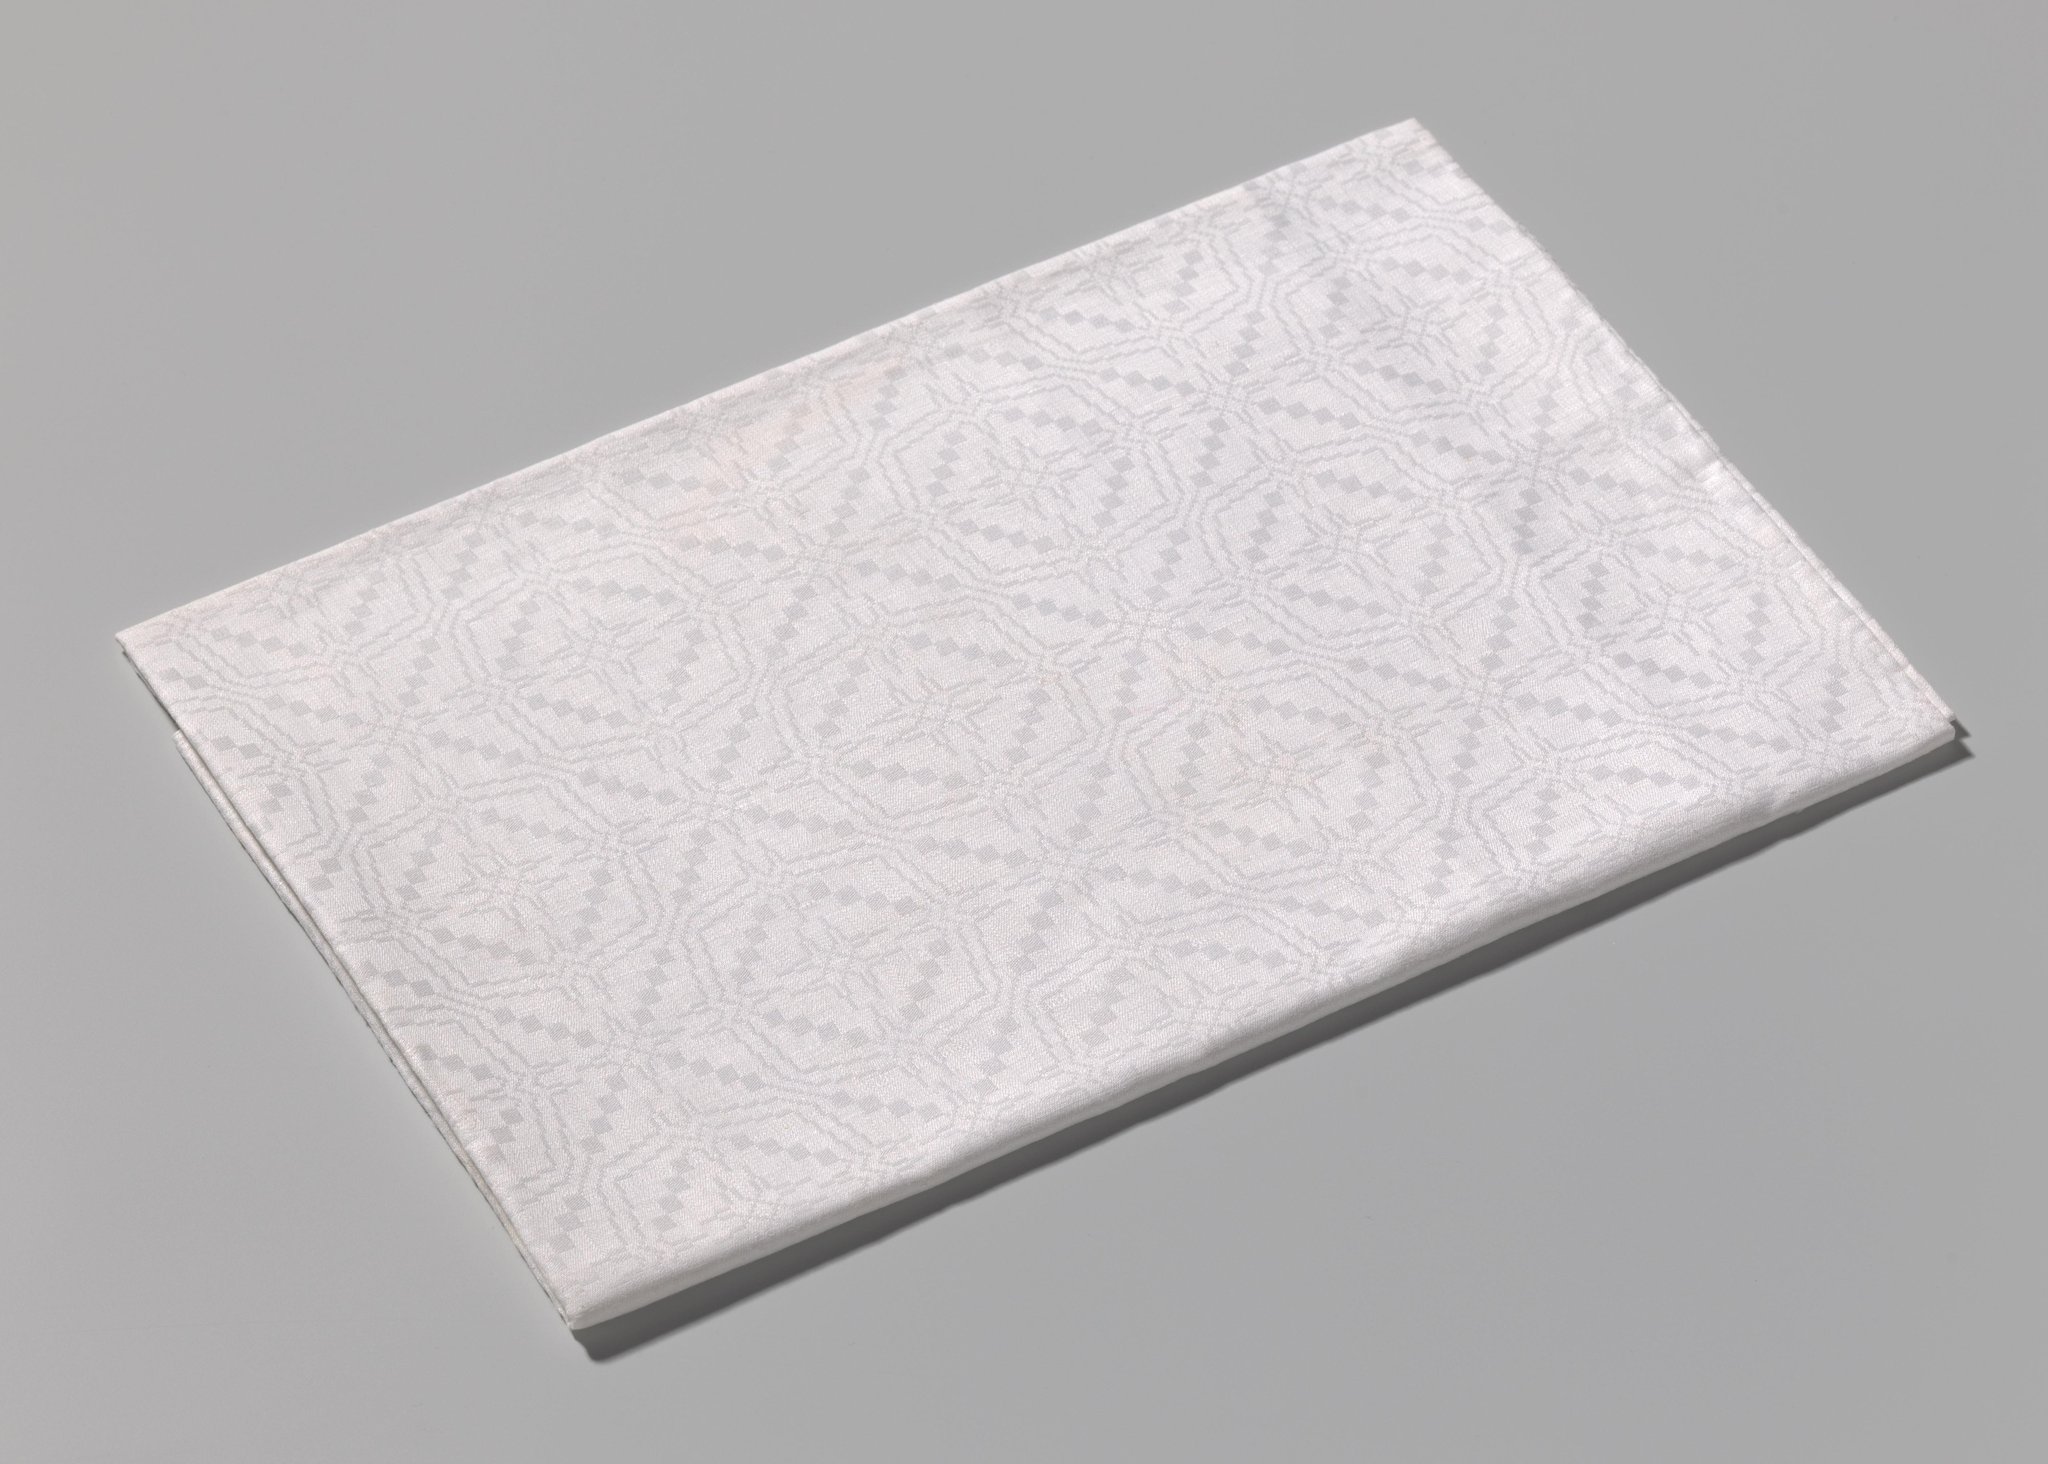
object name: napkin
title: Pellen. Merk: HW 38 p poonl.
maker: Anonymous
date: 1775-1799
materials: linen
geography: netherlands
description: Servet van wit linnen met een pellen patroon en randen, merk HW 38 p poonl.